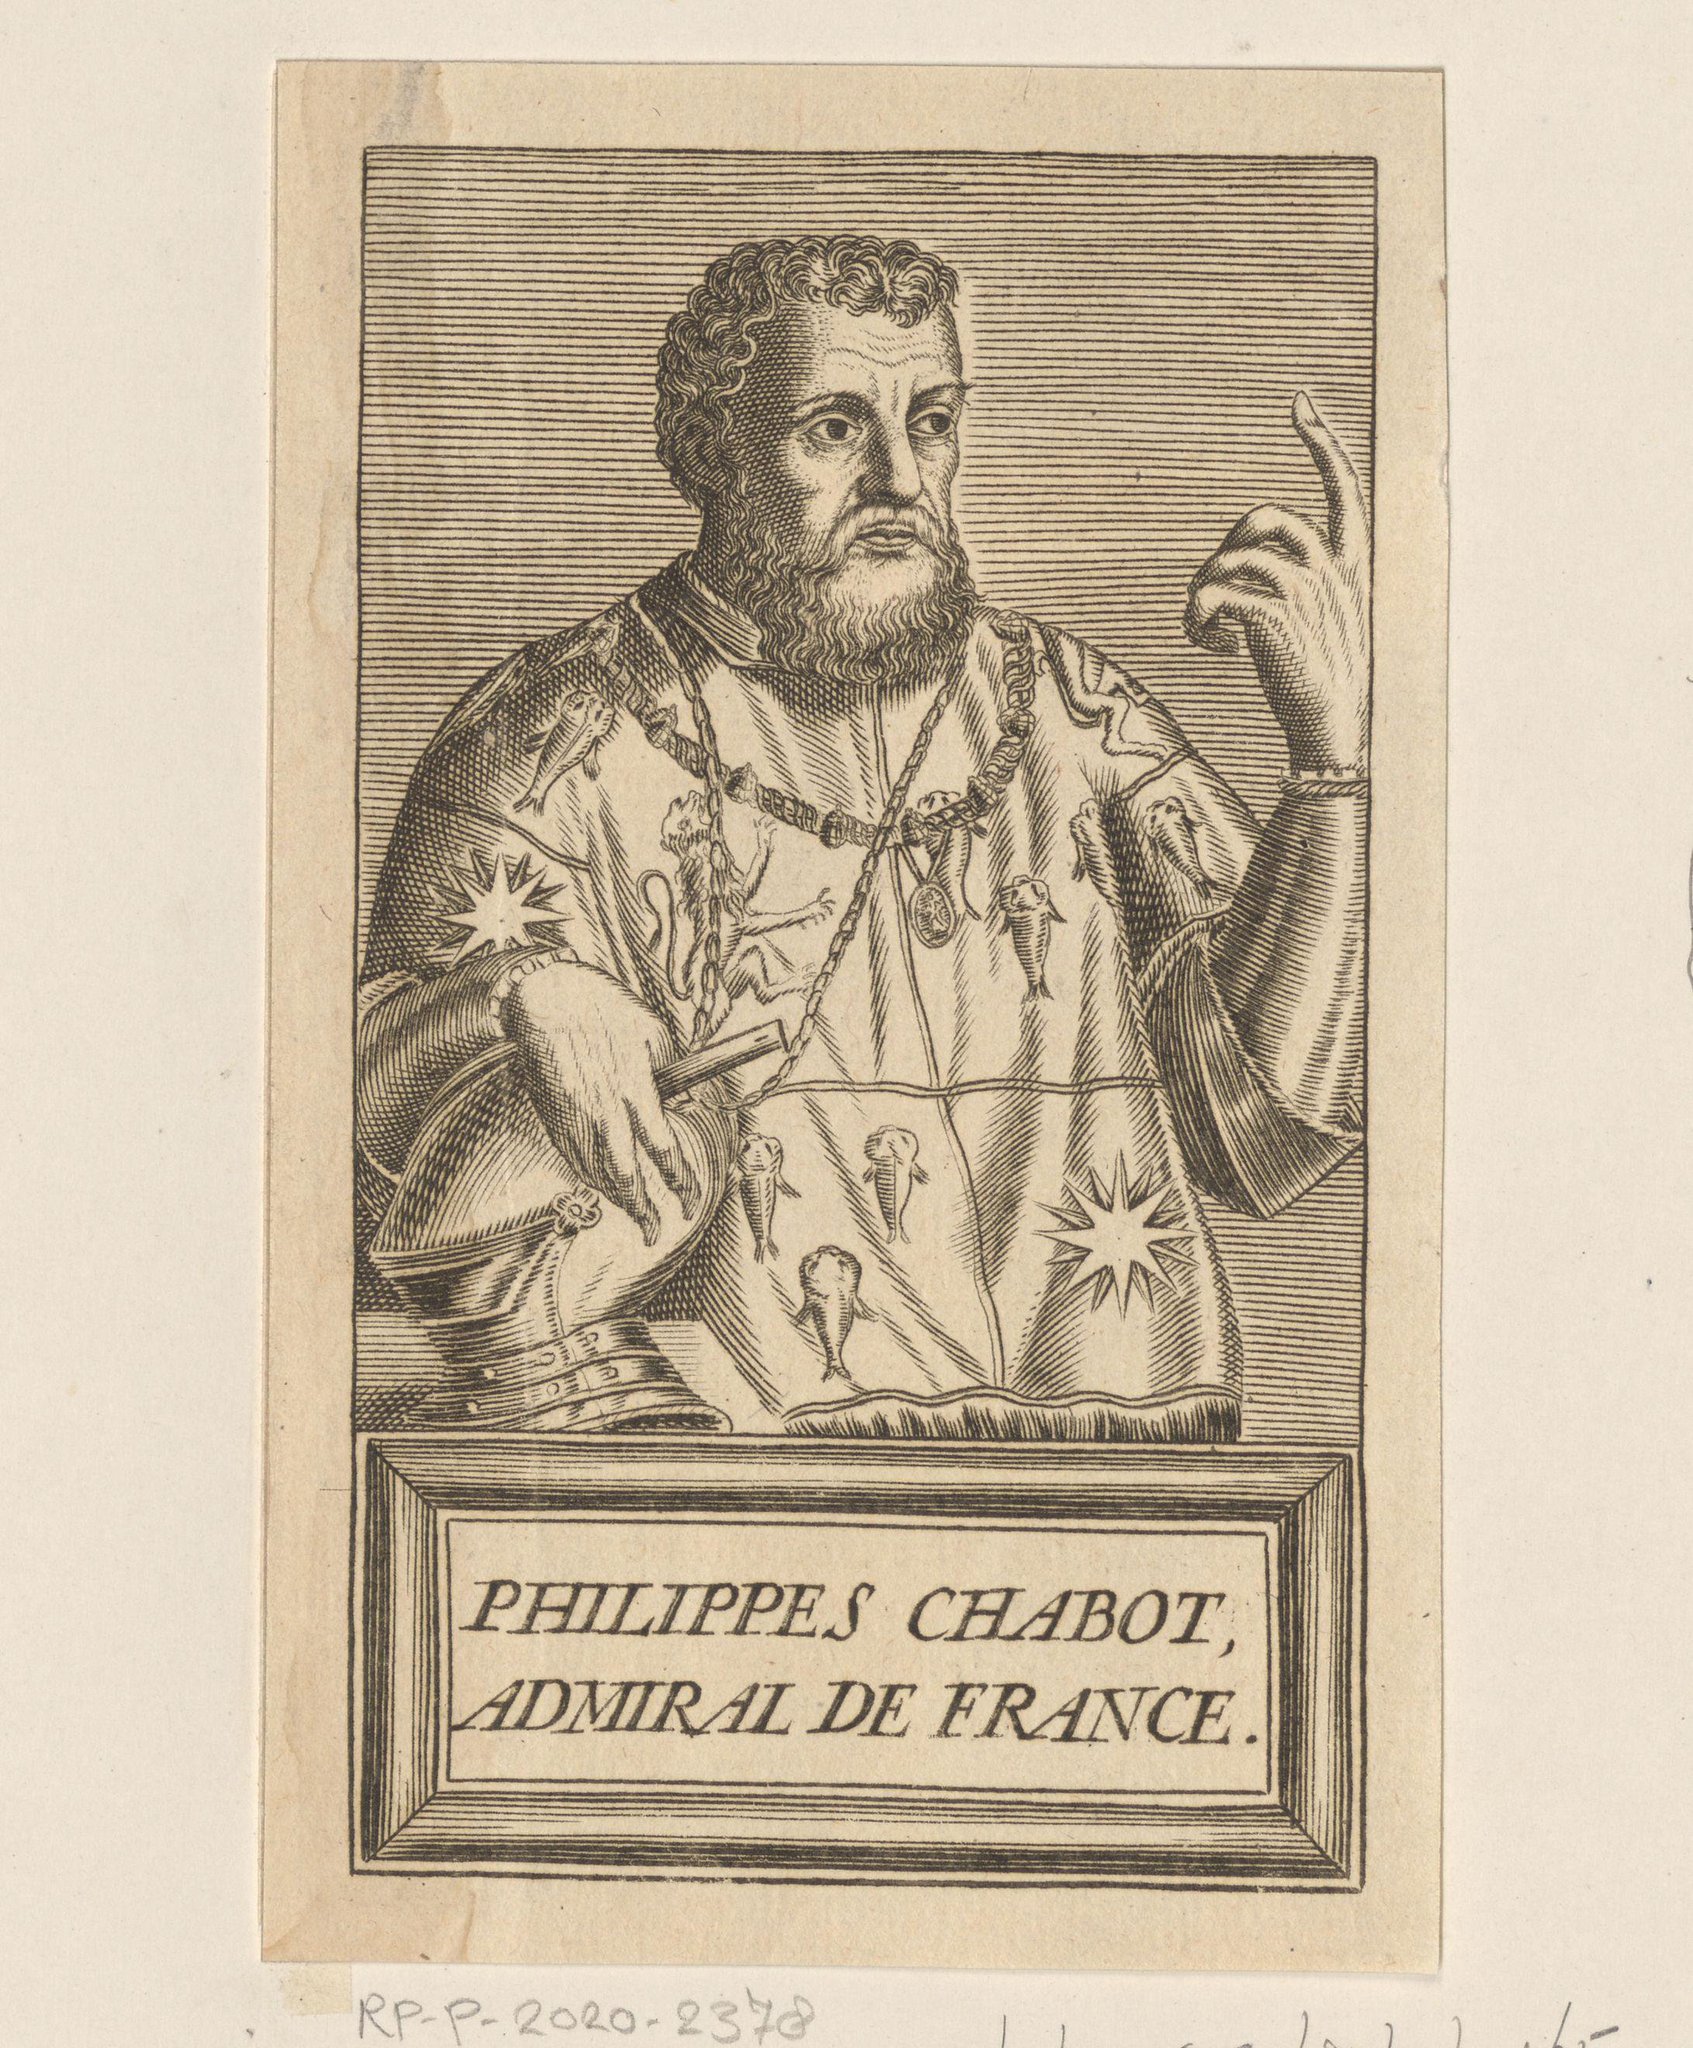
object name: print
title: Portret van Philippe de Chabot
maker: Anonymous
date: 1550-1650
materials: paper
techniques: engraving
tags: historical persons